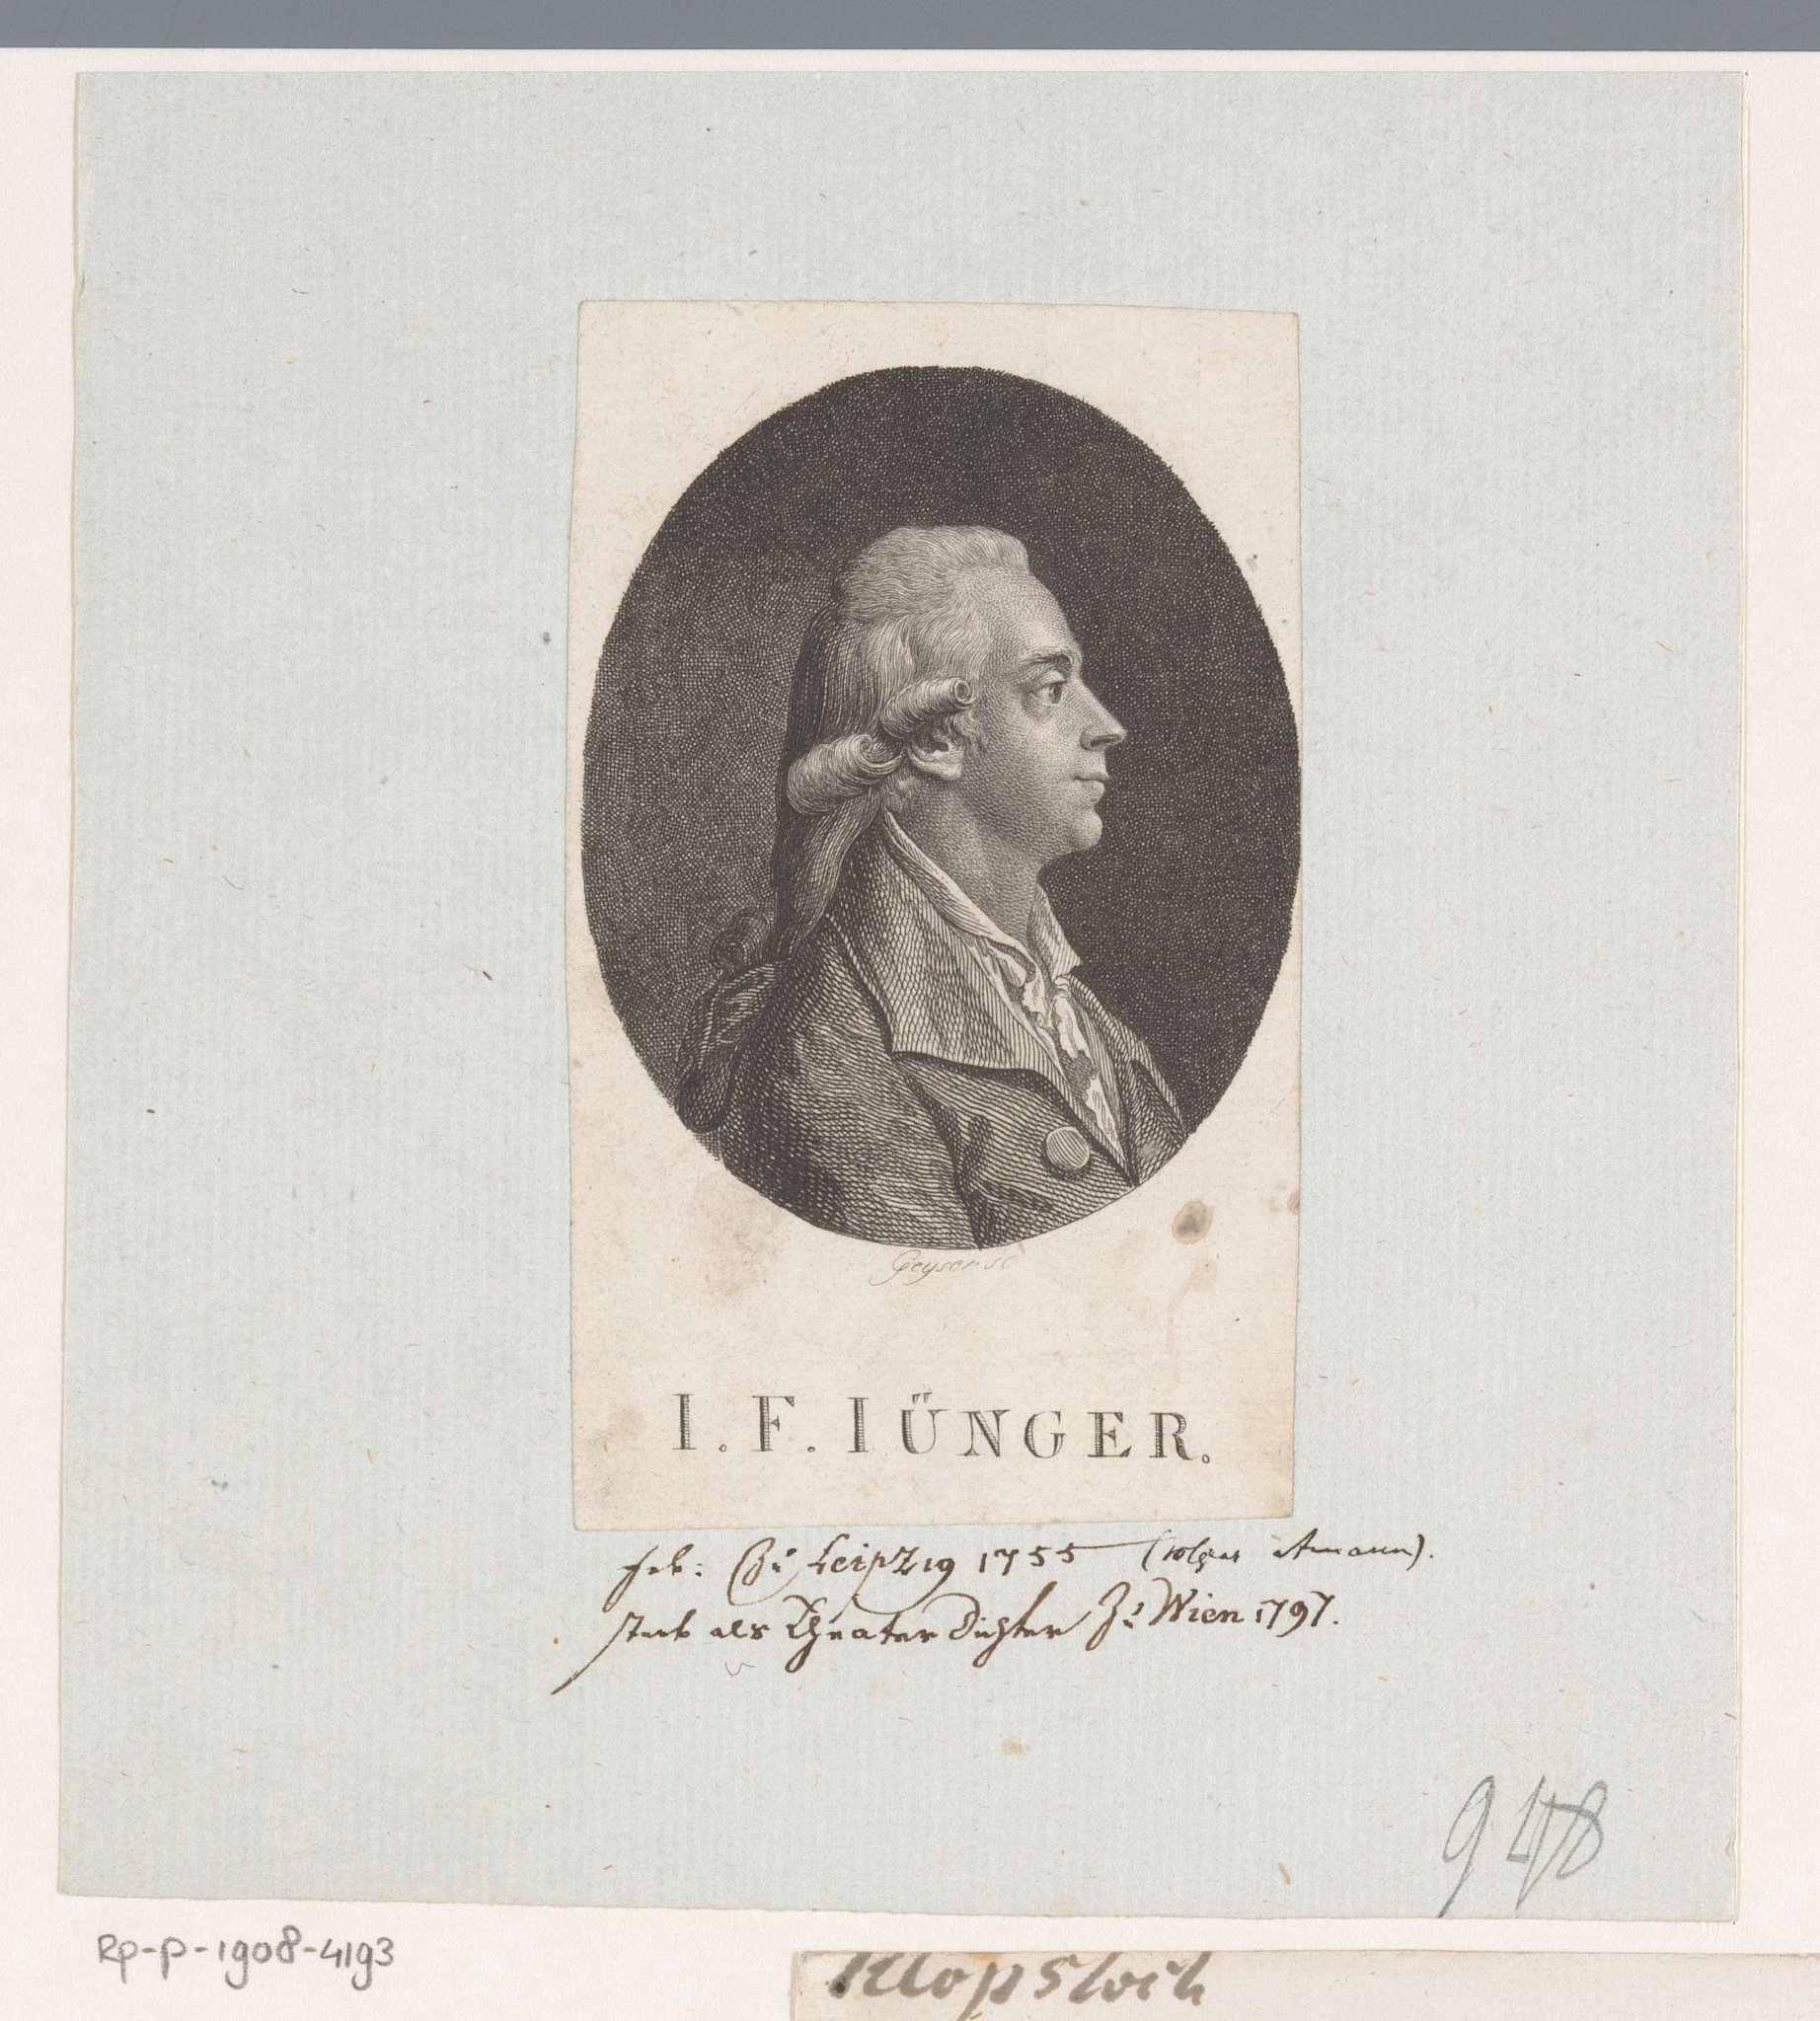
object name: print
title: Portret van Johann Friedrich Jünger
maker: christian gottlieb geyser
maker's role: print maker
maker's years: 1742-1803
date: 1766-1803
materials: paper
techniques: engraving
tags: historical persons, portrait of a writer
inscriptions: collector's mark: Lugt 2228